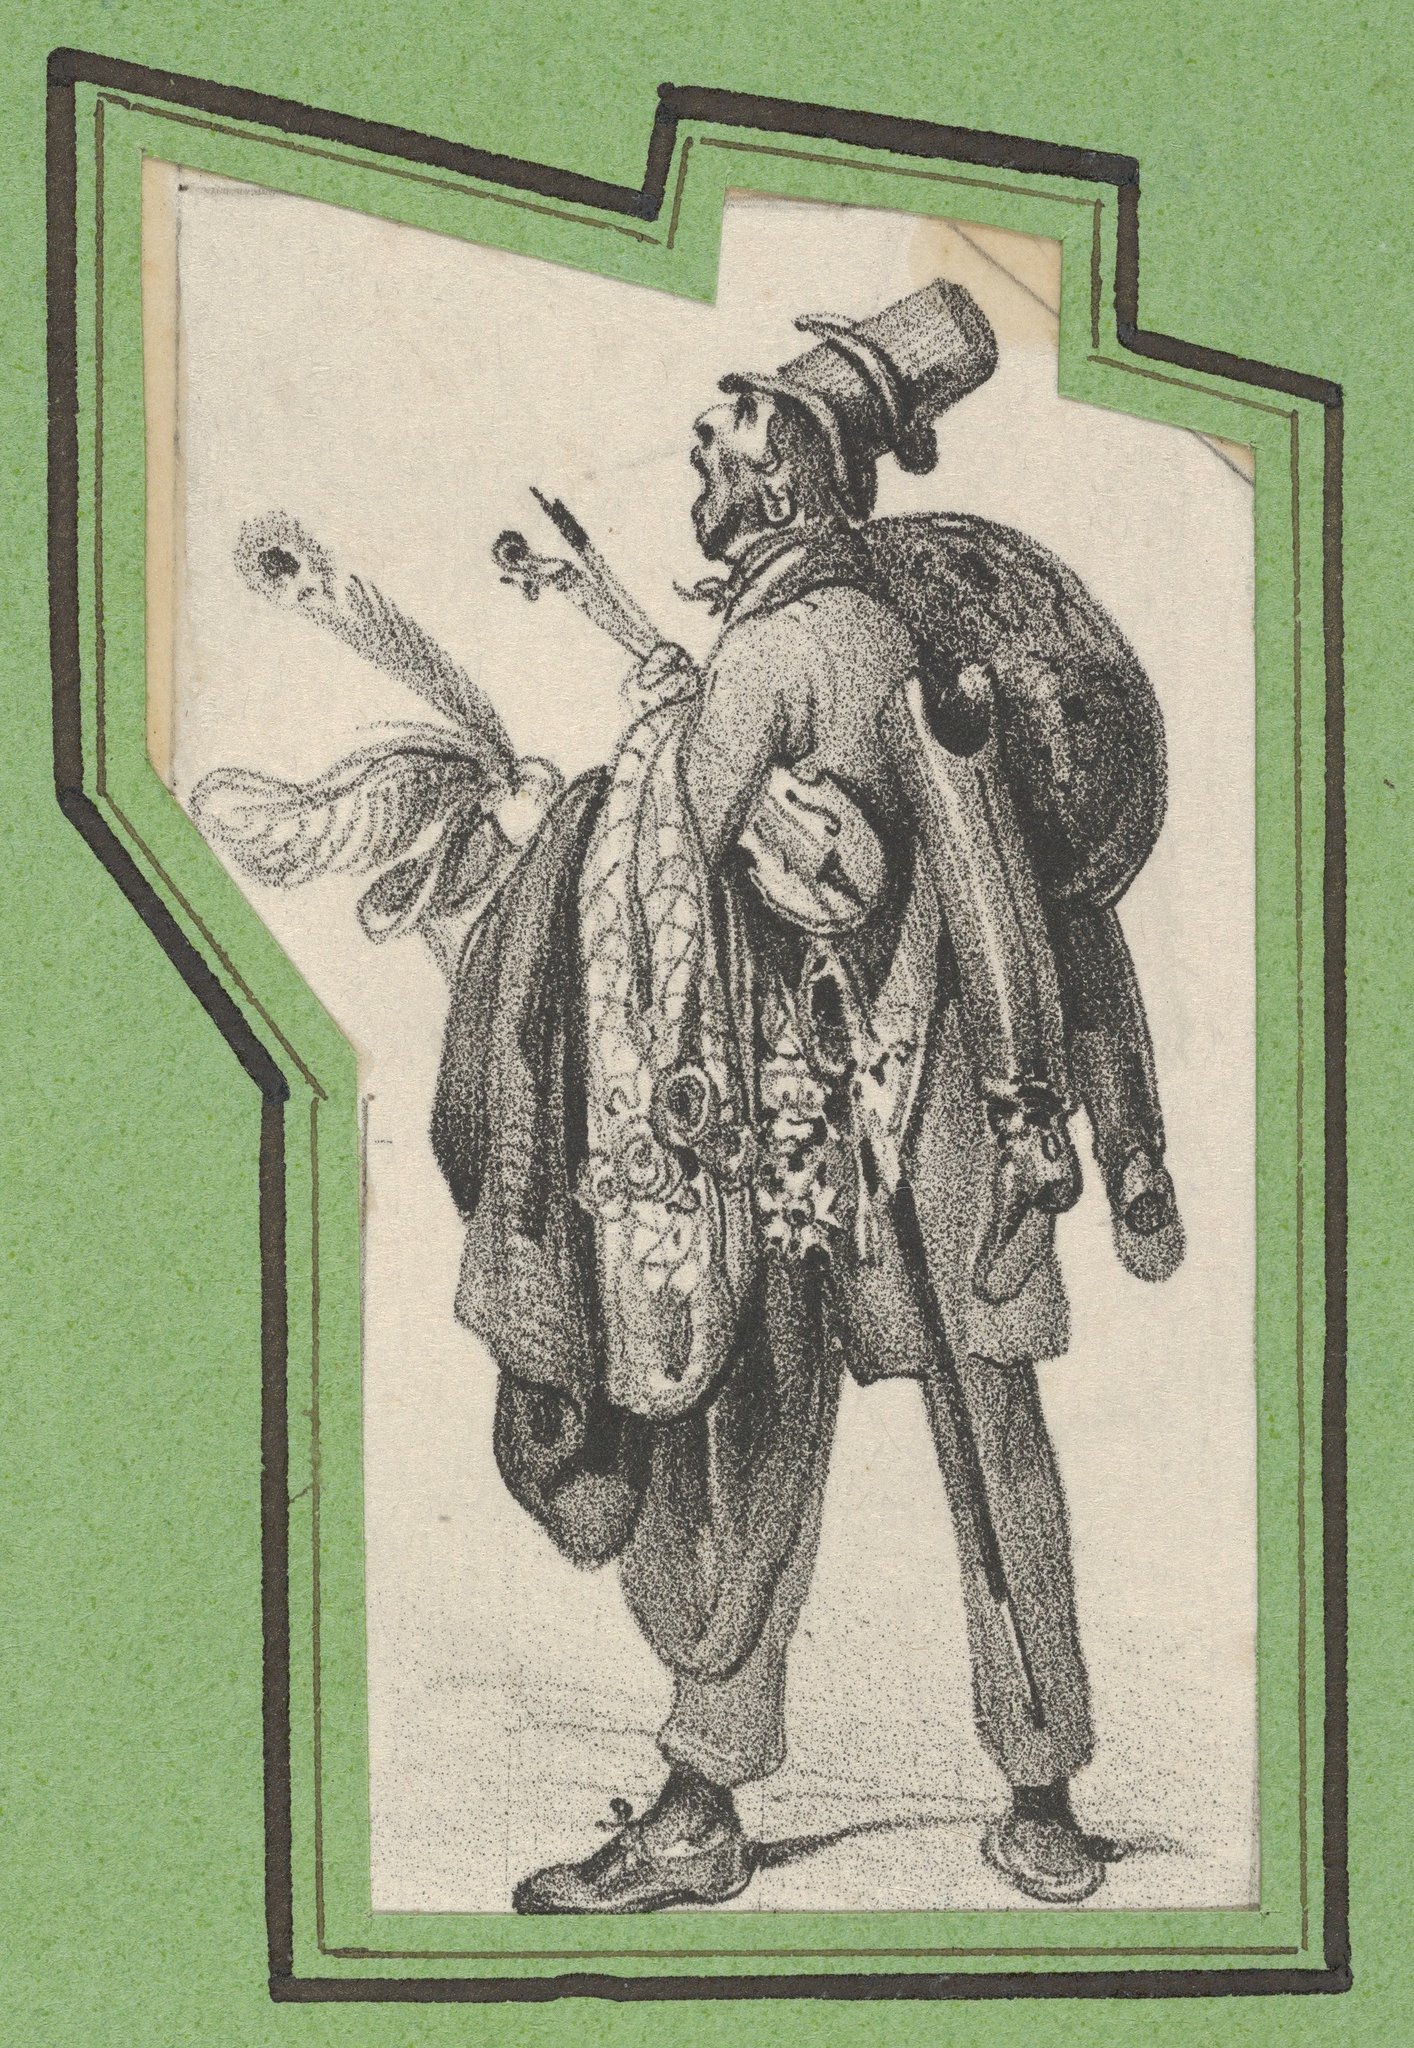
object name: print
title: Man wearing two hats and holding boots, jackets and a violin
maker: victor adam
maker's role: artist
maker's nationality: french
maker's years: 1801-1866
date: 1834-1866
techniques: lithograph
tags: boots,hats,men,profiles,violins